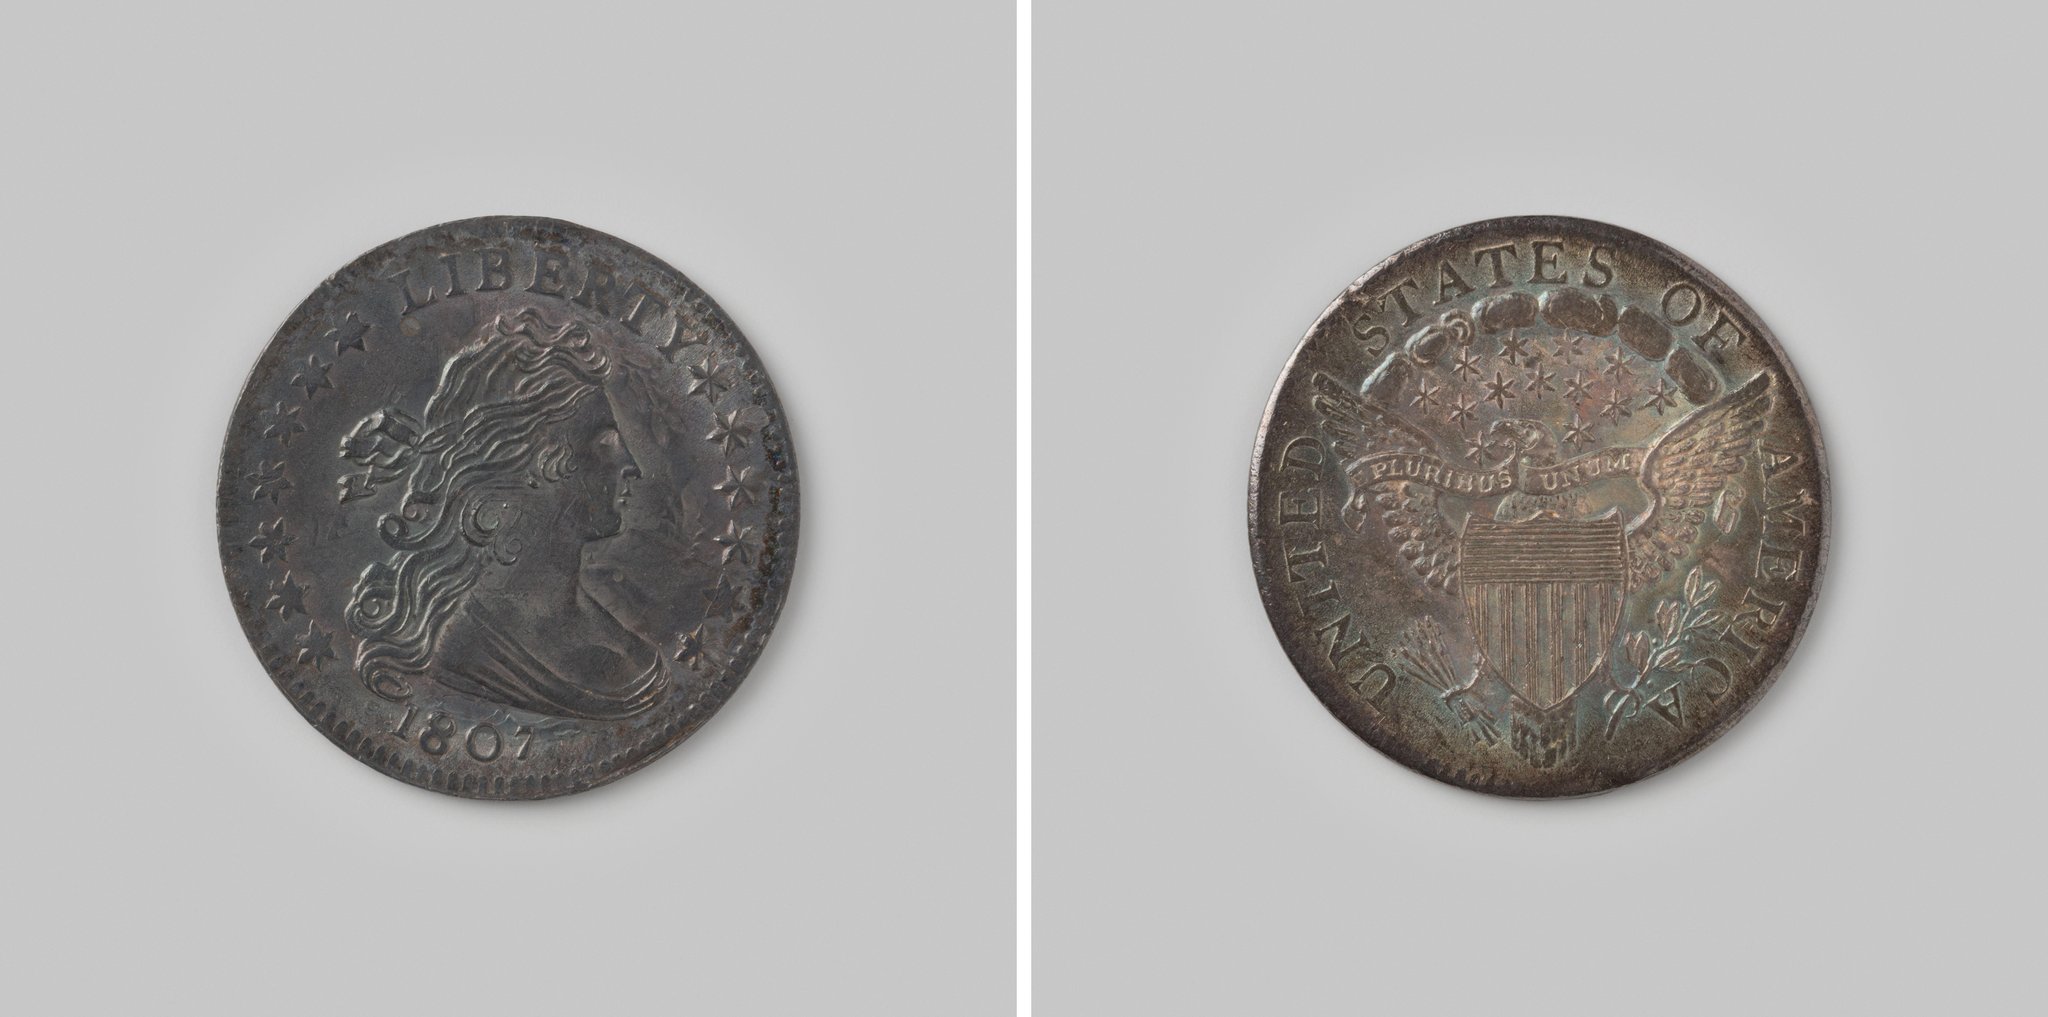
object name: coin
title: Verenigde Staten van Amerika, dime, 1807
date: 1807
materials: silver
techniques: striking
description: Zilveren munt. Voorzijde: liberty naar rechts, Daaromheen sterren. Jaartal onderaan. Keerzijde: adelaar met gespreide vleugels met in zijn linker klauw tak en in zijn rechter klauw pijlenbundel en op zijn borst wapenschild, omkijkend naar links. In zijn bek een banderol met opschrift. Daarboven sterren en een ring van wolken. Kartelrand.